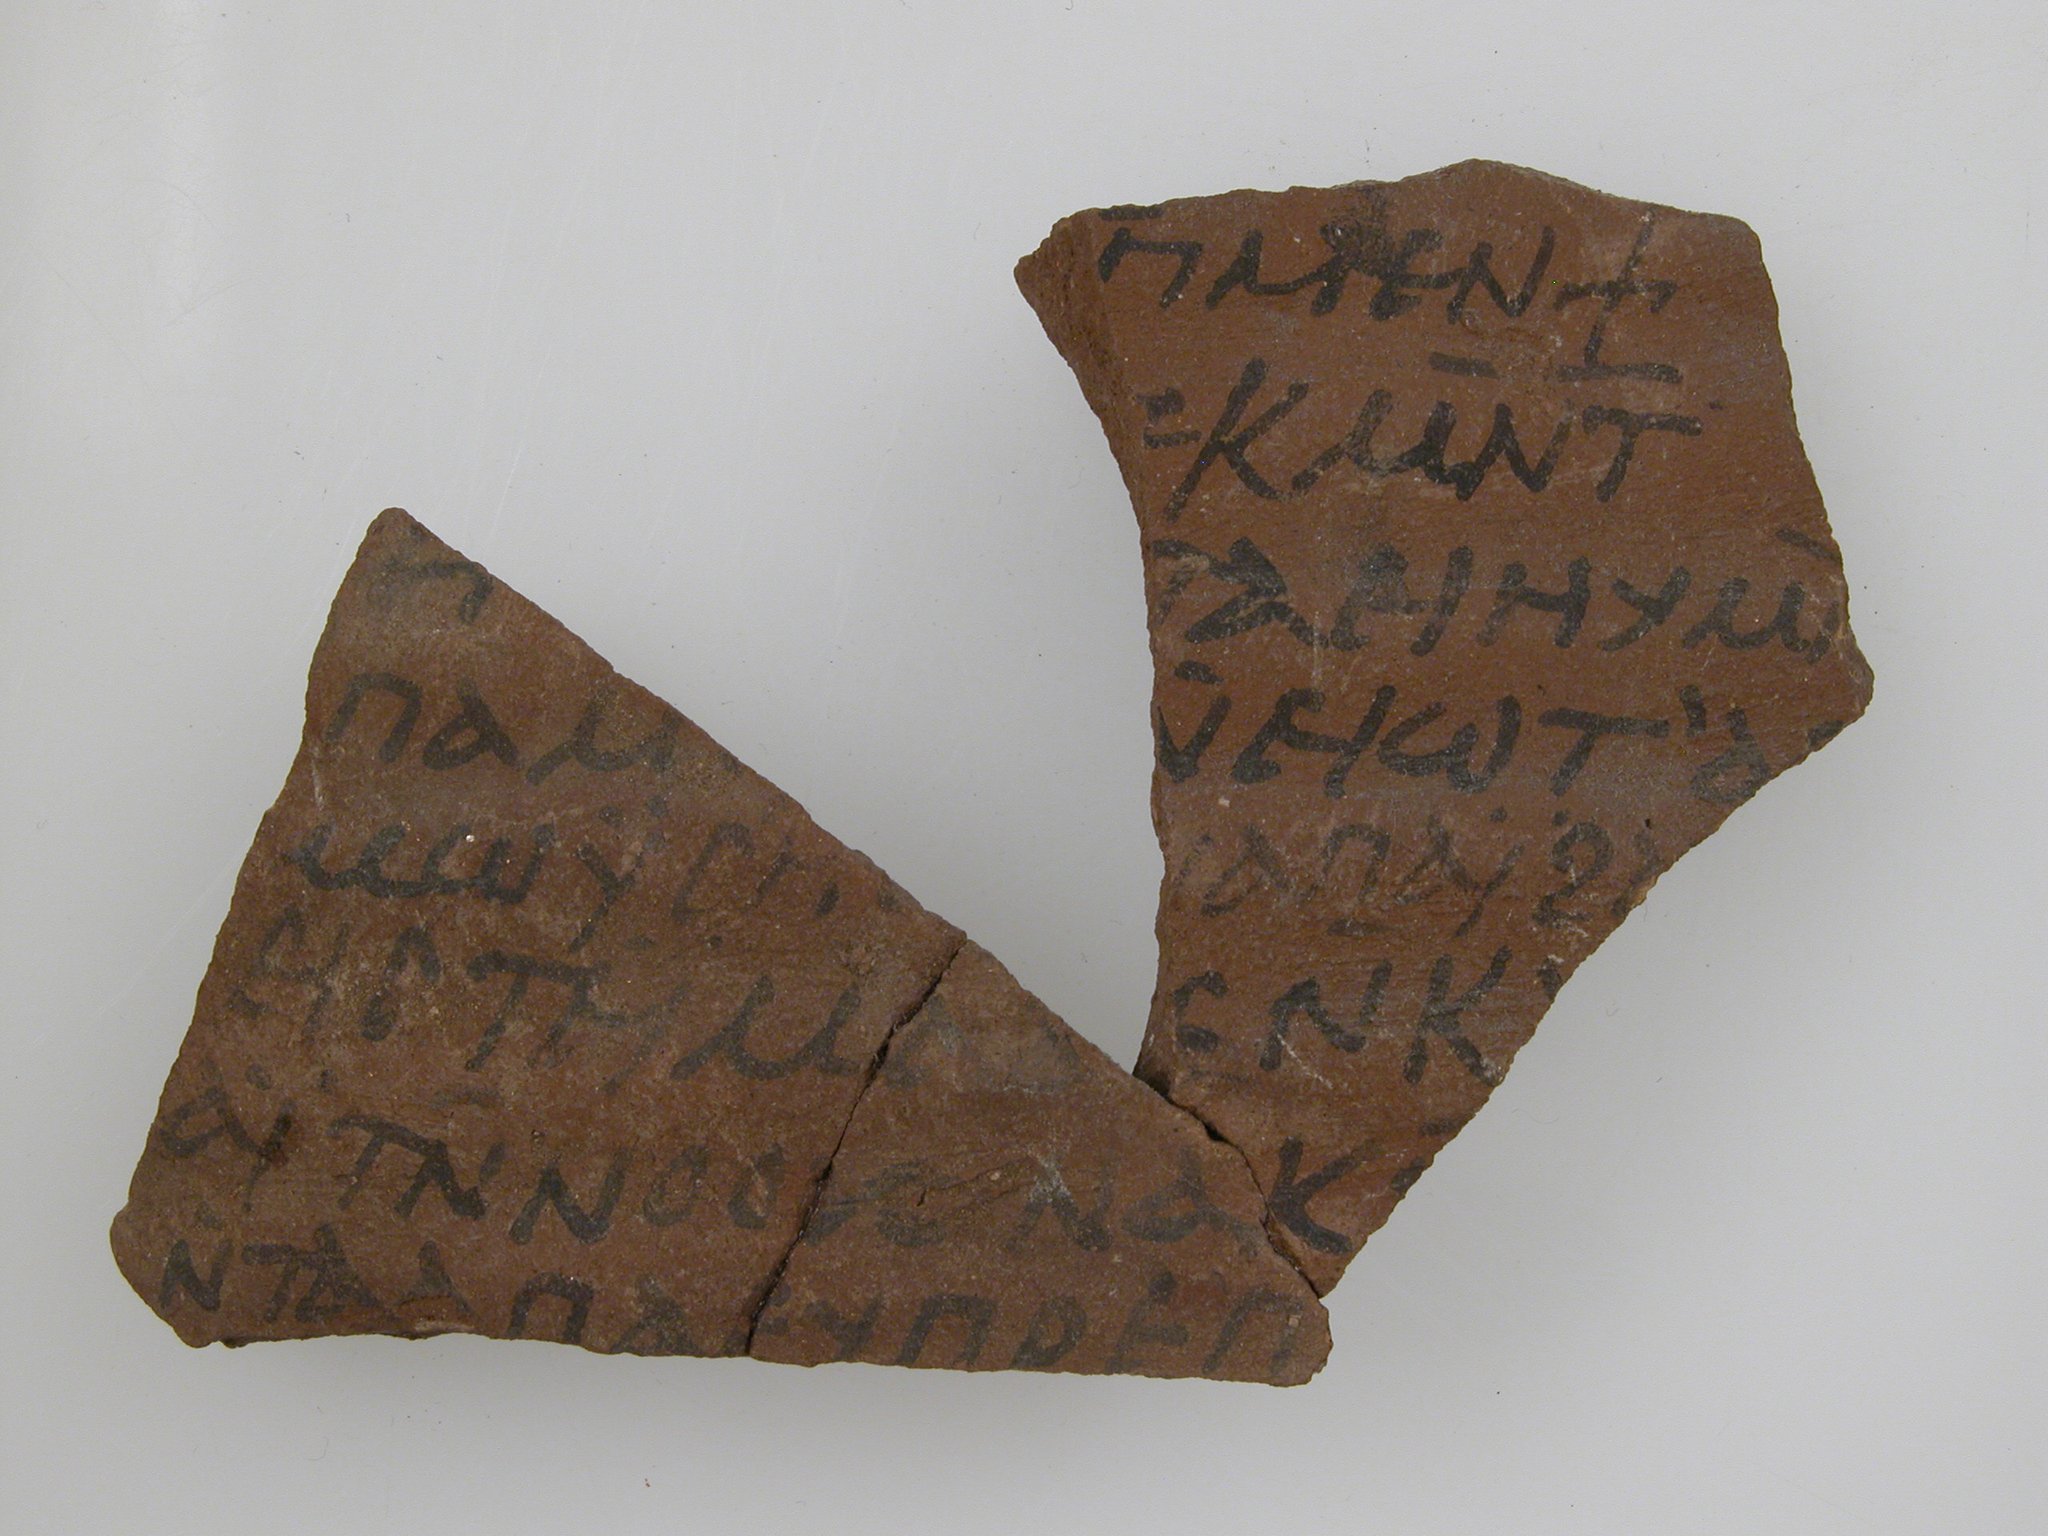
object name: ostrakon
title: Ostrakon with a Letter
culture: coptic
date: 600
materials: ink, pottery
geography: egypt